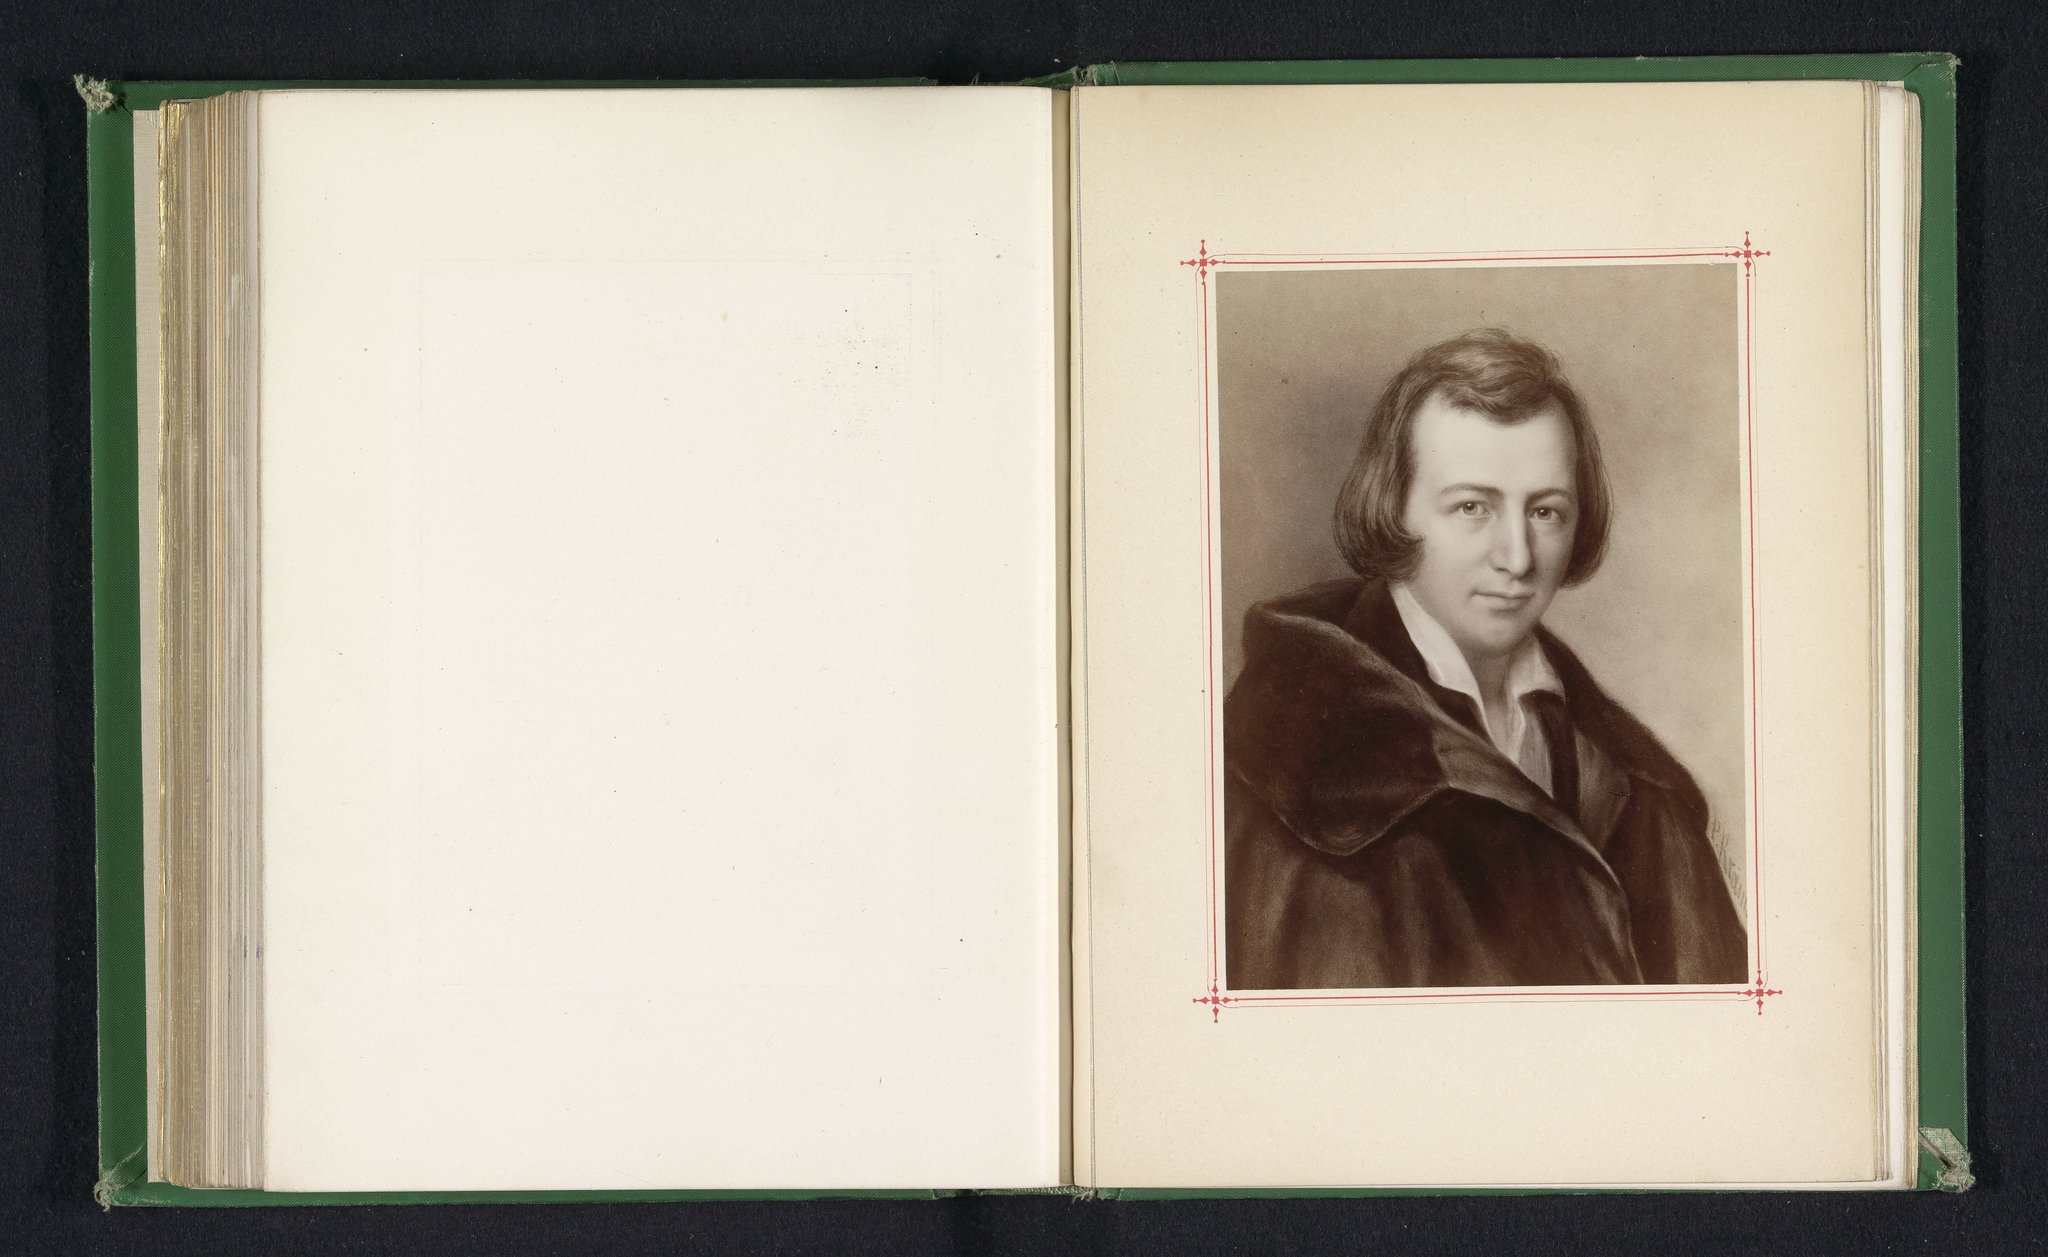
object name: page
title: Fotoreproductie van een portret van Heinrich Heine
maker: Anonymous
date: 1868-1878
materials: photographic support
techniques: albumen print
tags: writer, poet, author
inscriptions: name: ‘P. Kräm[...]’